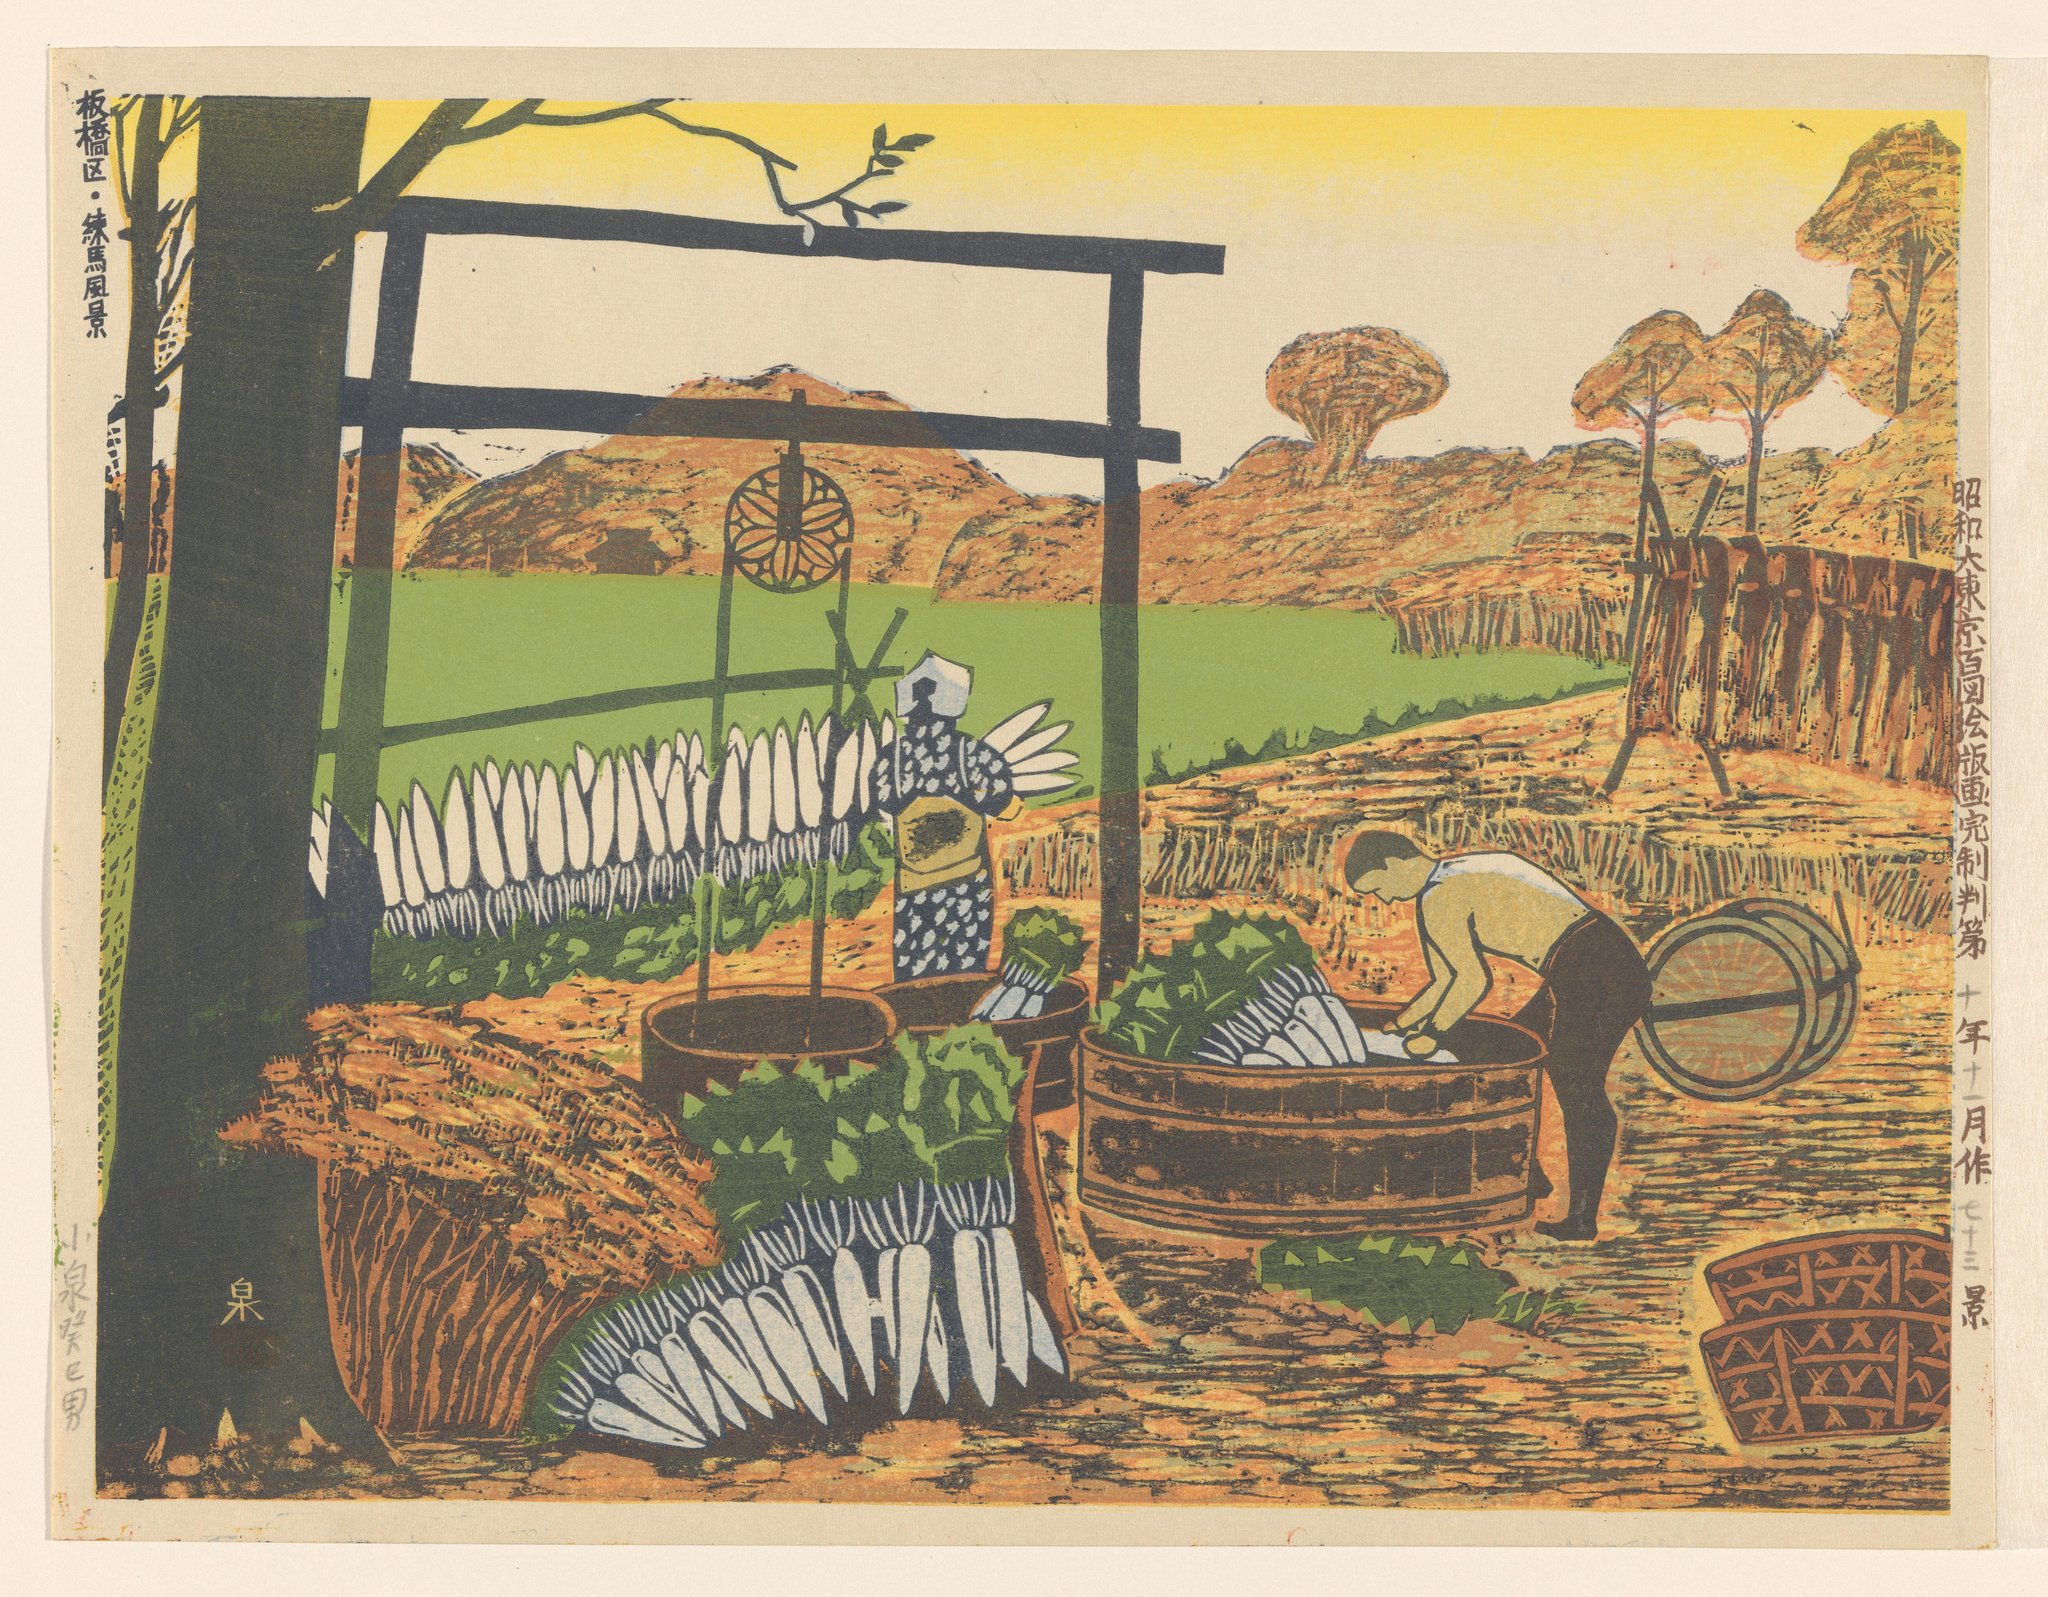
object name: print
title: One hundred pictures of Great Tokyo in the Shōwa era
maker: koizumi kishio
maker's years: 1893-1945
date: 1911-1935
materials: paper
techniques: woodcut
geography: japan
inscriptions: signature: ‘小泉癸巳男’, seal: ‘Koizumi Kishio.’, signature: ‘泉’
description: Een man en vrouw omgeven door een herfstachtig boeren landschap zijn bezig met het sorteren van daikon, grote witte Japanse radijzen. In september 1928 begon Koizumi Kishio aan zijn ambitieuze plan om honderd landschapsprenten met scènes in Tokyo volledig zelf te ontwerpen, hiervan zelf de drukblokken te snijden en zelf de prenten te drukken. De aanleiding voor het project was grote verandering die Tokyo onderging door de verwoestende Grote Kantō-aardbeving van 1923 en de wederopbouw die daarop volgde. Kishio maakt een bewuste verwijzing naar de bekende serie ‘Honderd beroemde gezichten op Edo’ door Utagawa Hiroshige (1797–1858), met prenten van locaties in Edo—de oude benaming voor Tokyo. Kishio toont overwegend moderne gebouwen, instituten en mensen die de tijdsgeest van de jaren 1920 en 1930 weerspiegelen. Sommige prenten onthullen daarentegen een nostalgische blik op overblijfselen uit het oude Edo. Kishio verkocht de prenten aan de hand van een abonnement met een limiet van vijftig leden, die elke maand een of twee prenten zouden ontvangen. Het project begon met negen abonnementen, maar al na de tweede maand werden meerdere daarvan opgezegd en slechts vier mecenassen bleven lid tot en met de voltooiing van de serie. Hij bracht het honderdste ontwerp uit in 1937. Zijn leermeester Ishii Hakutei schreef een inleiding in 1938 die Kishio verwerkte tot een prent en toevoegde aan de set. Tussen 1939 en 1940 maakte hij nog eens negen extra ontwerpen. Met acht van deze ontwerpen verving hij oudere nummers uit de serie, mogelijk omdat hij niet tevreden was met de composities. Uiteindelijk lukte het Kishio om tien complete sets te verkopen aan de shin hanga-uitgever Watanabe Shōzaburō en liet hiervoor speciale houten dozen maken. Deze prent behoort tot een van die tien sets.